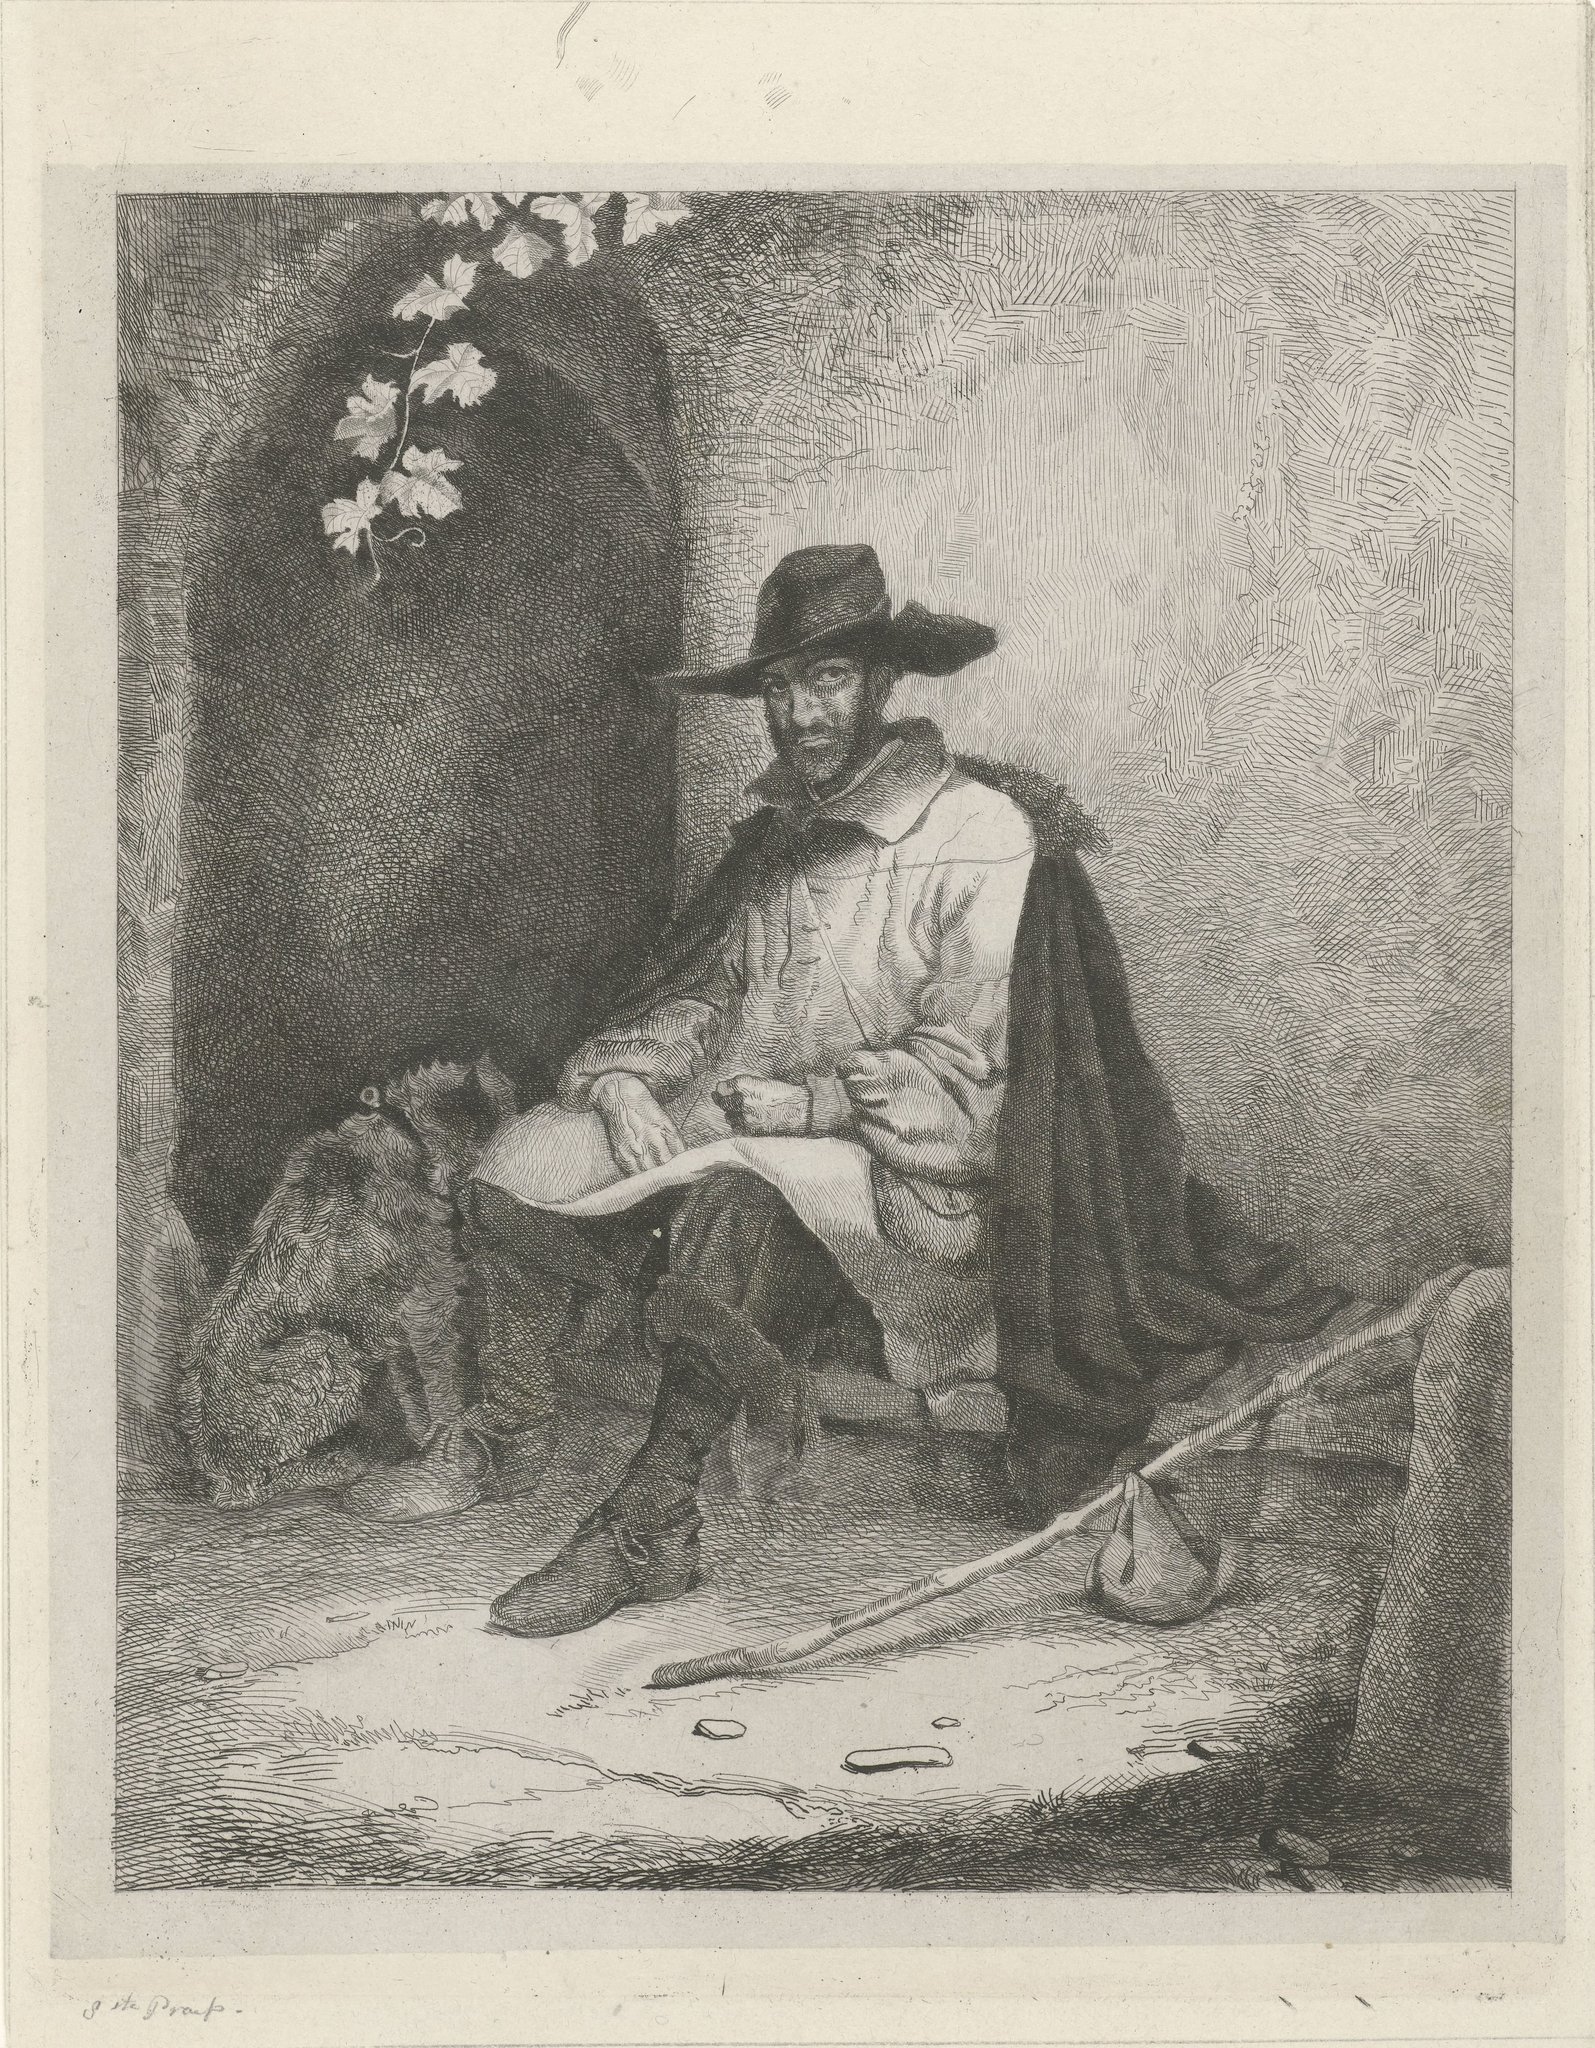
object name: print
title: Rustende reiziger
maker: jacobus ludovicus cornet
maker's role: draughtsman, print maker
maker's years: 1815-1882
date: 1851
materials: paper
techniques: etching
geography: leiden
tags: (traveller) resting in the open air, dog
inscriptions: collector's mark: Lugt 2166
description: Een reiziger rust uit voor de ingang van een grot. Naast hem een hond. De man draagt een mantel en een hoge hoed.